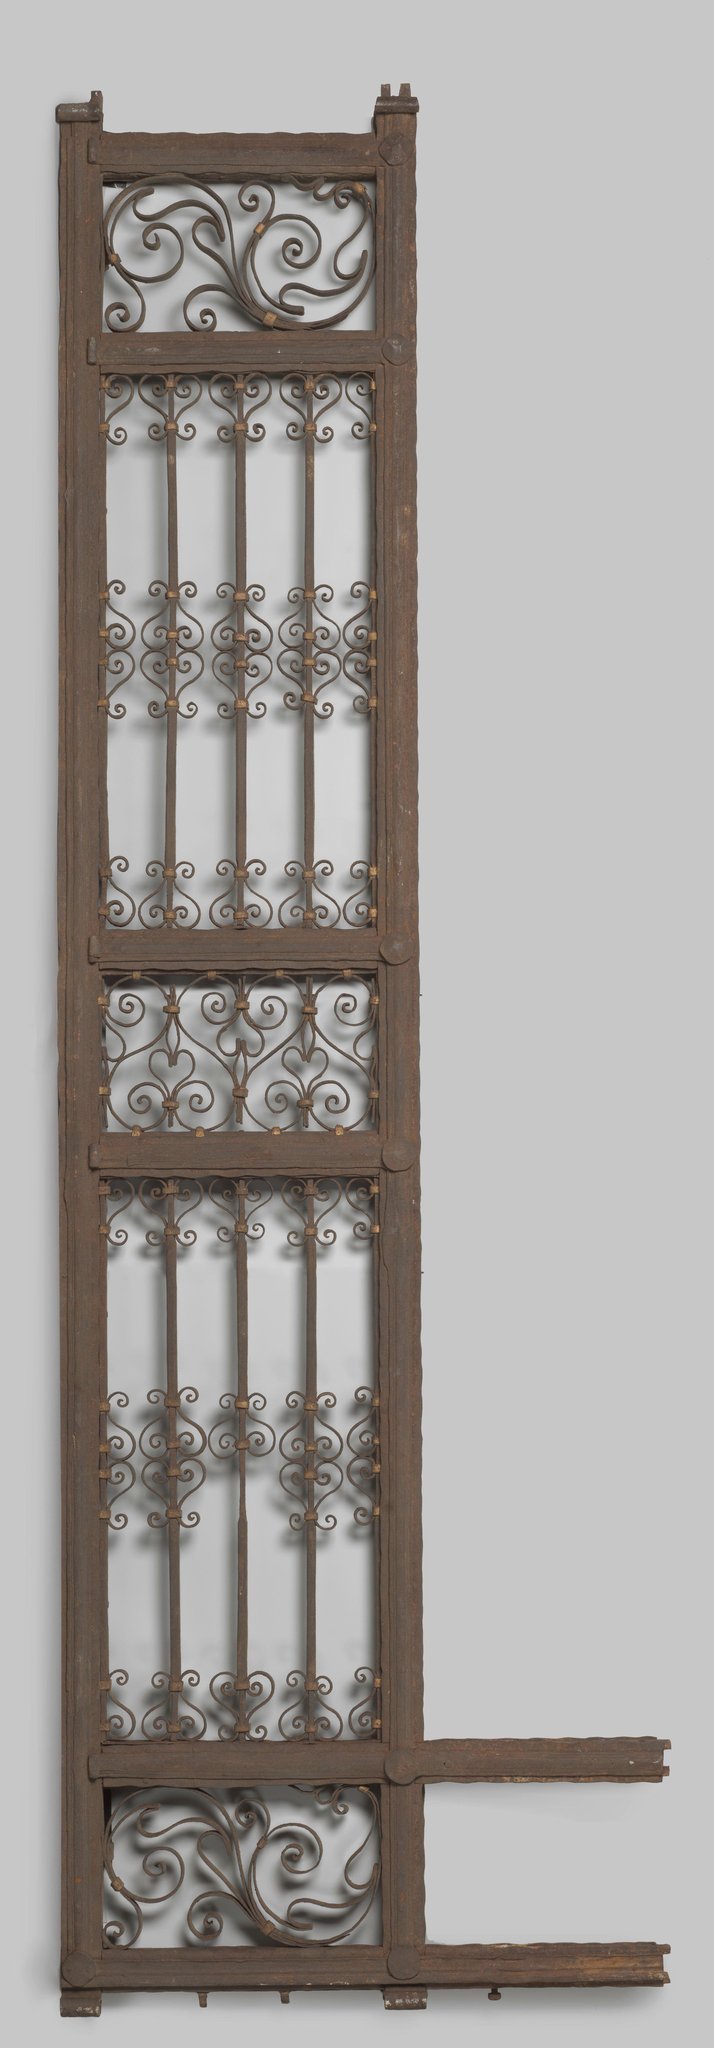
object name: hekwerk en hekwerkelement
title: Zijpaneel van hekwerk en hekelement, versierd met hartvormig samengestelde voluten. Bekroningen in de vorm van punt met S-voluten. Uit verz. Mannheimer.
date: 1600-1699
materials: iron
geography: italy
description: Een vierdelige hekwerk bestaande uit twee deuren en twee zijpanelen; Het geraamte is samengesteld uit verticaal en horizontaal geplaatste regels, welke laatste het hekwerk over de gehele breedte in twee brede tussen drie smalle banen indelen. In de grote banen bevinden zich verticaal geplaatste achtzijdige spijlen met boven en onder één rij en in het midden een dubbele rij van samengestelde S-voluten die hartvormige motieven vormen. Elke deel van het hek wordt bekroond door een puntig motief van S-voluten.